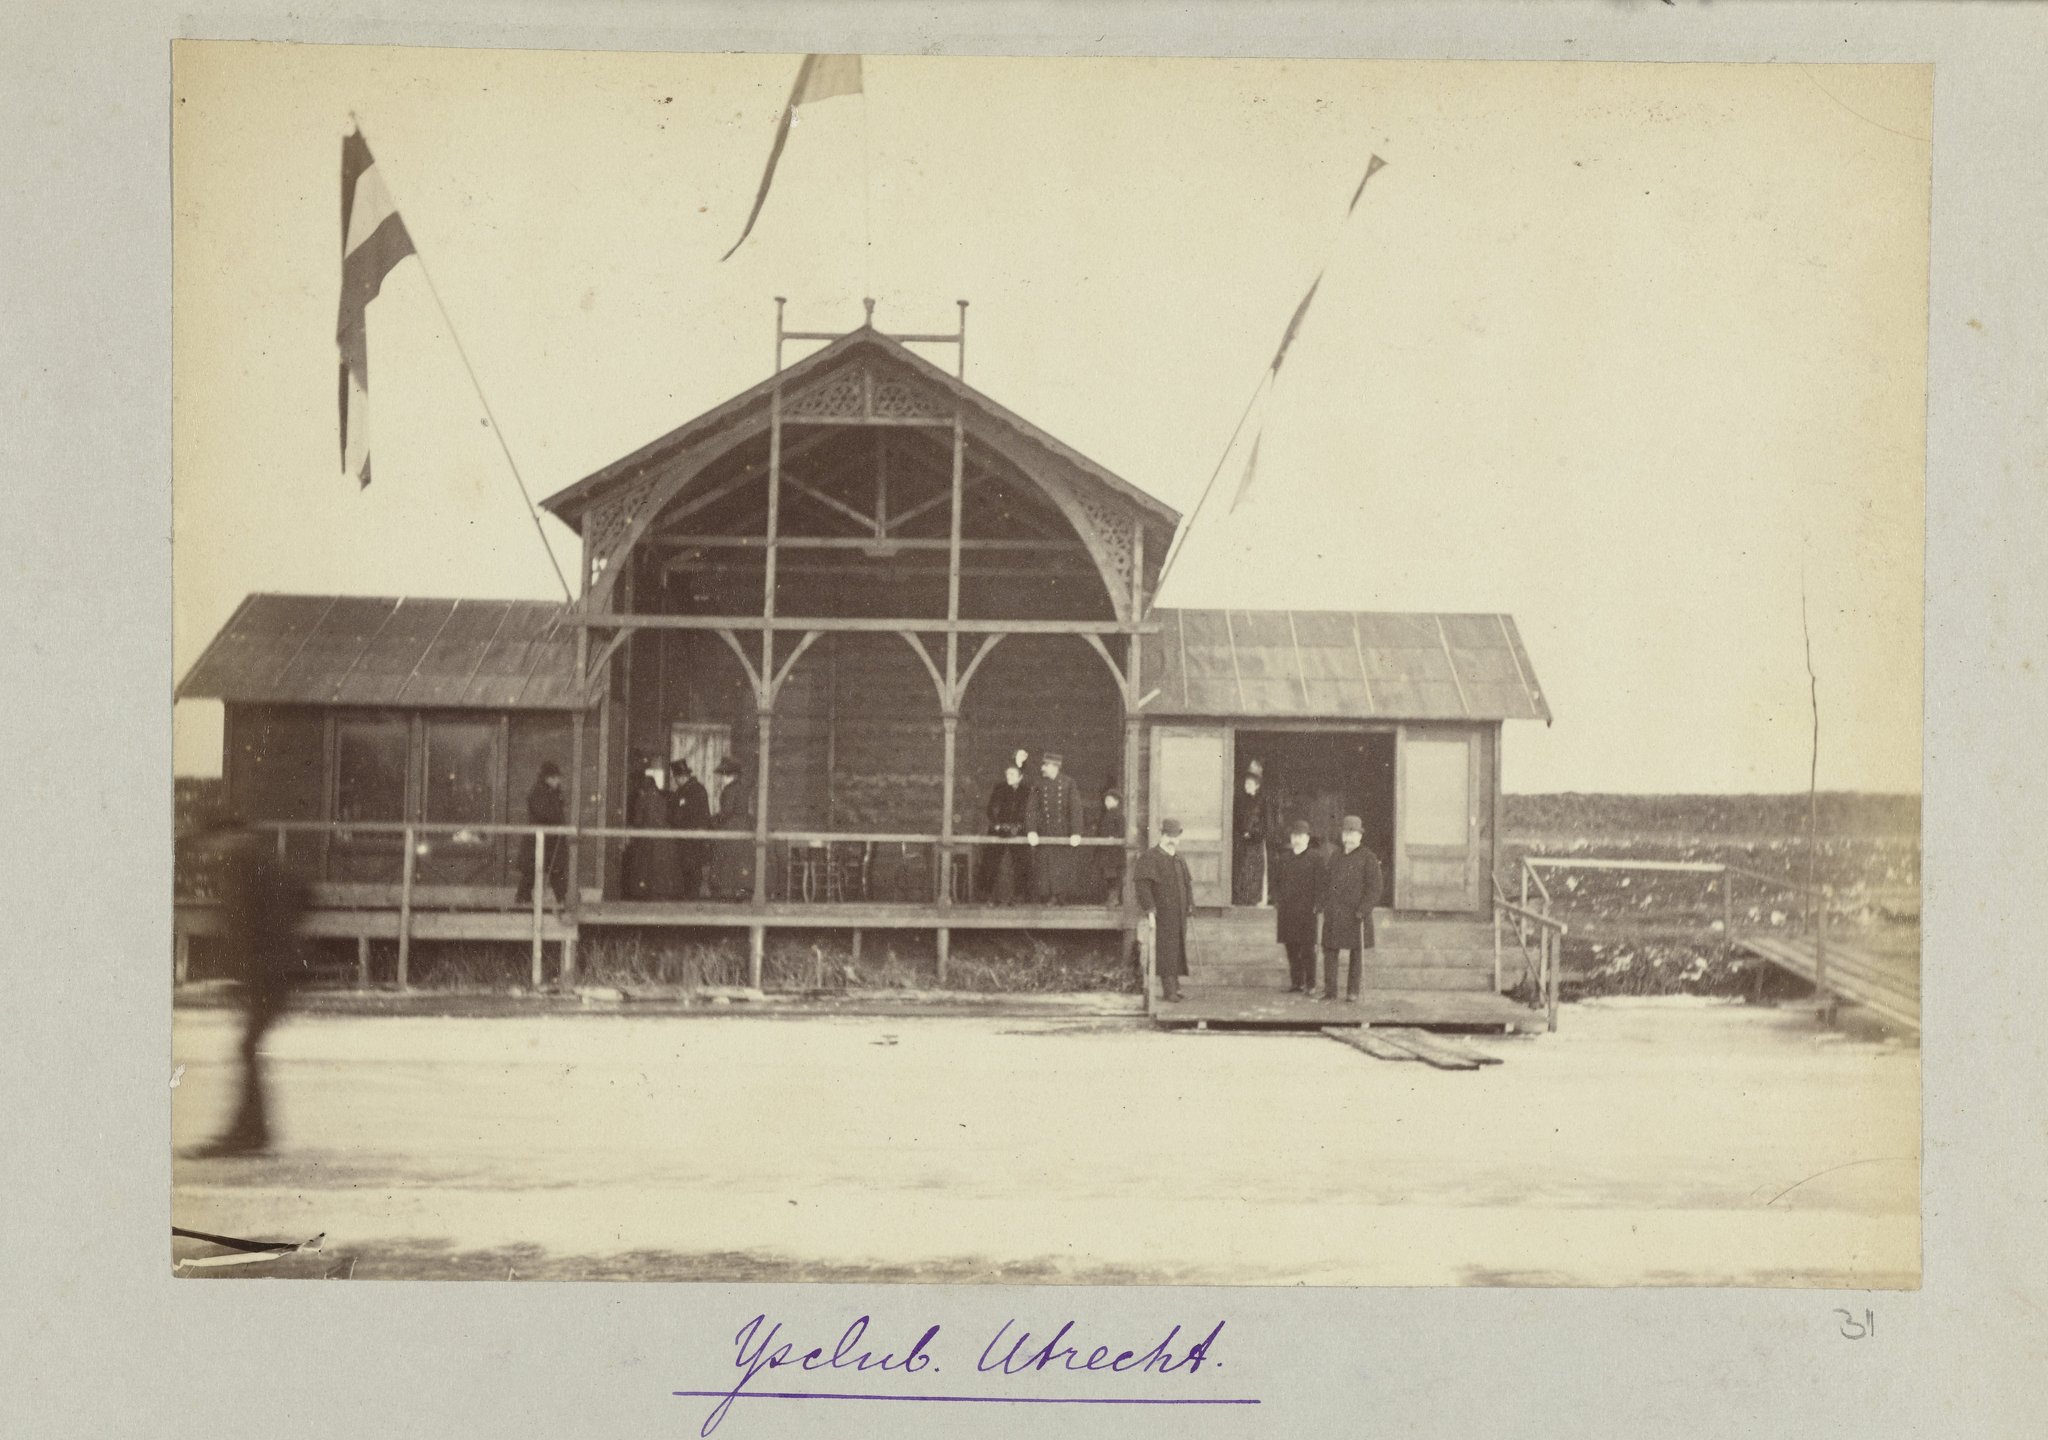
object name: photograph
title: Clubgebouw van IJsclub Utrecht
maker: henry pauw van wieldrecht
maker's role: fotograaf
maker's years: 1863-1912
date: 1888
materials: paper, photographic support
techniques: albumen print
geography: netherlands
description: Het clubgebouw van IJsclub Utrecht met wapperende vlag. Voor het gebouw staat een aantal mannen met bolhoed en lange overjas. Met onderschrift: IJsclub Utrecht.